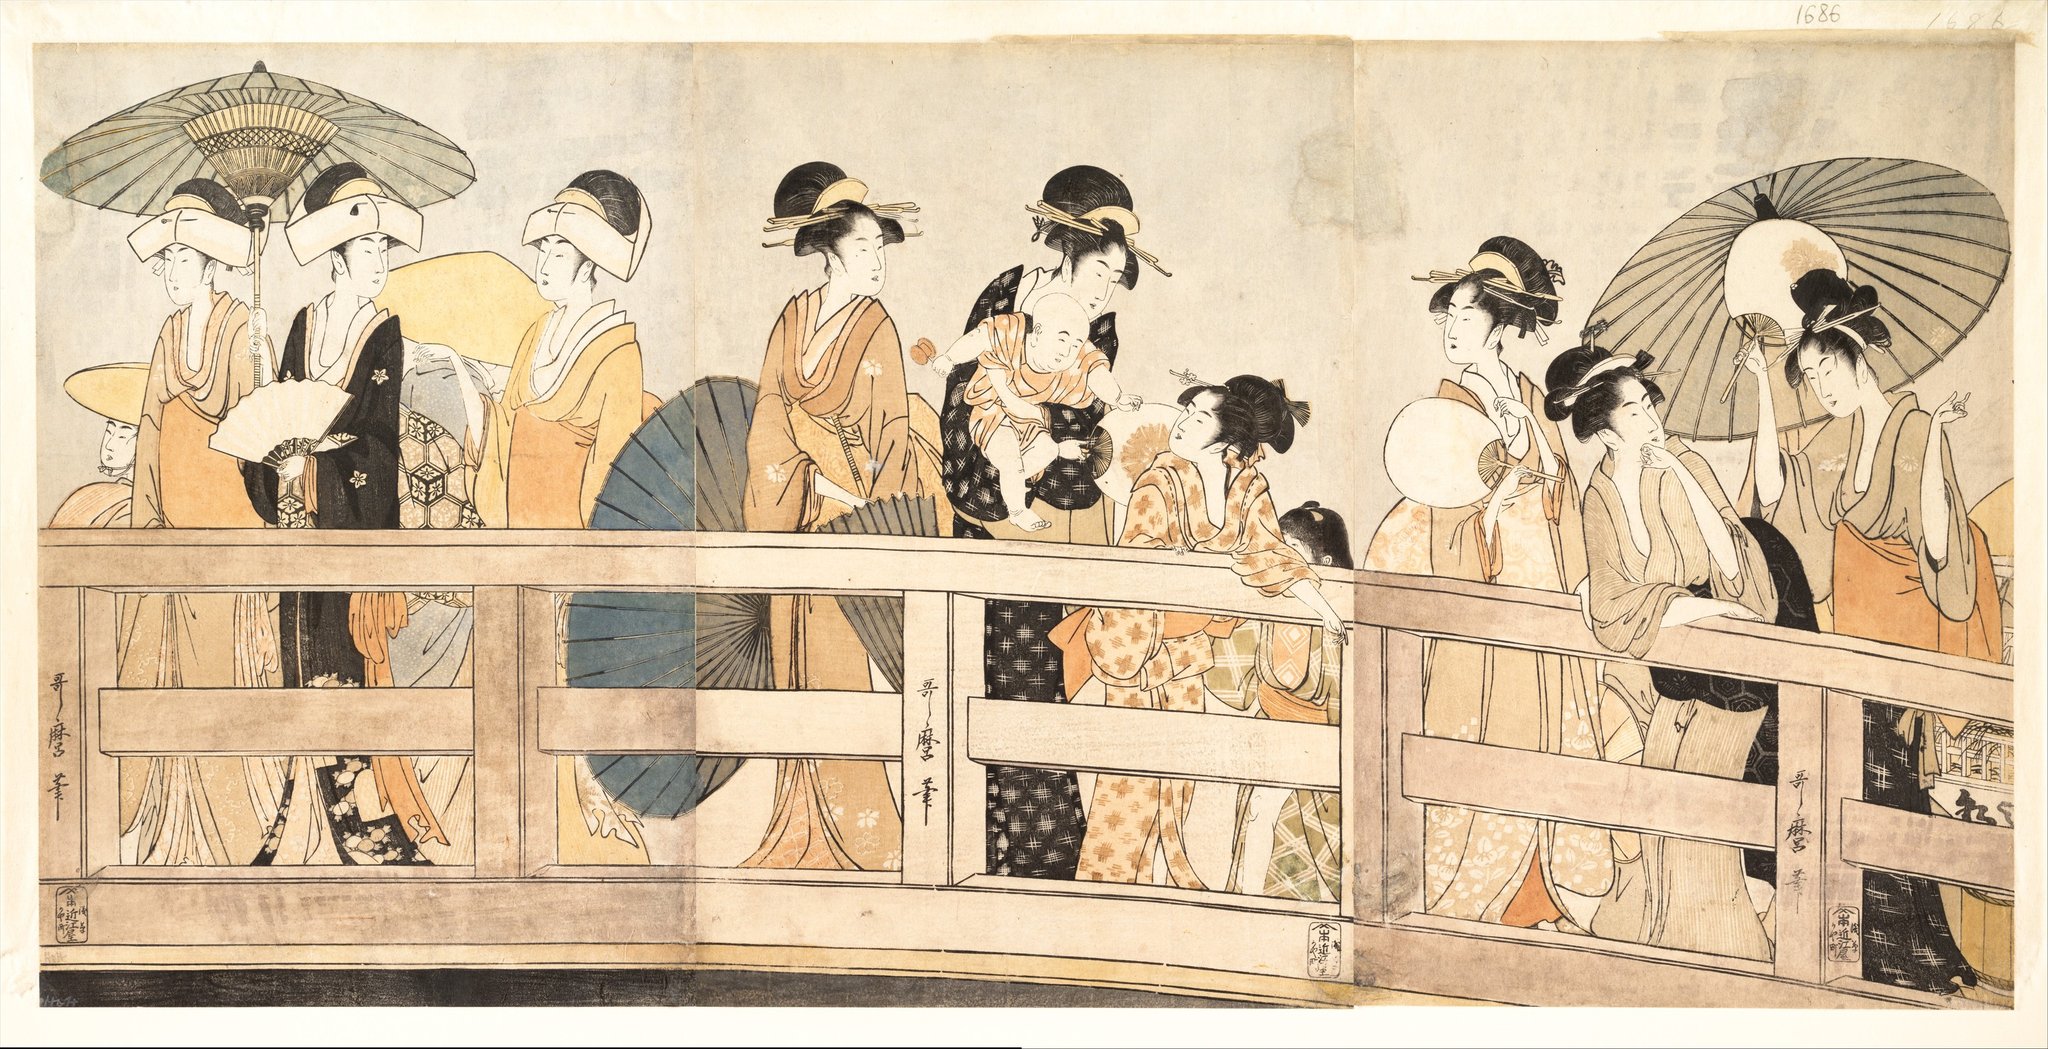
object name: print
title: Enjoying the Cool Evening Breeze on and under the Bridge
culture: japanese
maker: kitagawa utamaro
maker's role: artist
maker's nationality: japanese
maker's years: 1754-1806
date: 1800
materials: ink, paper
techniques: woodblock print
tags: bridges,fans,women,evening